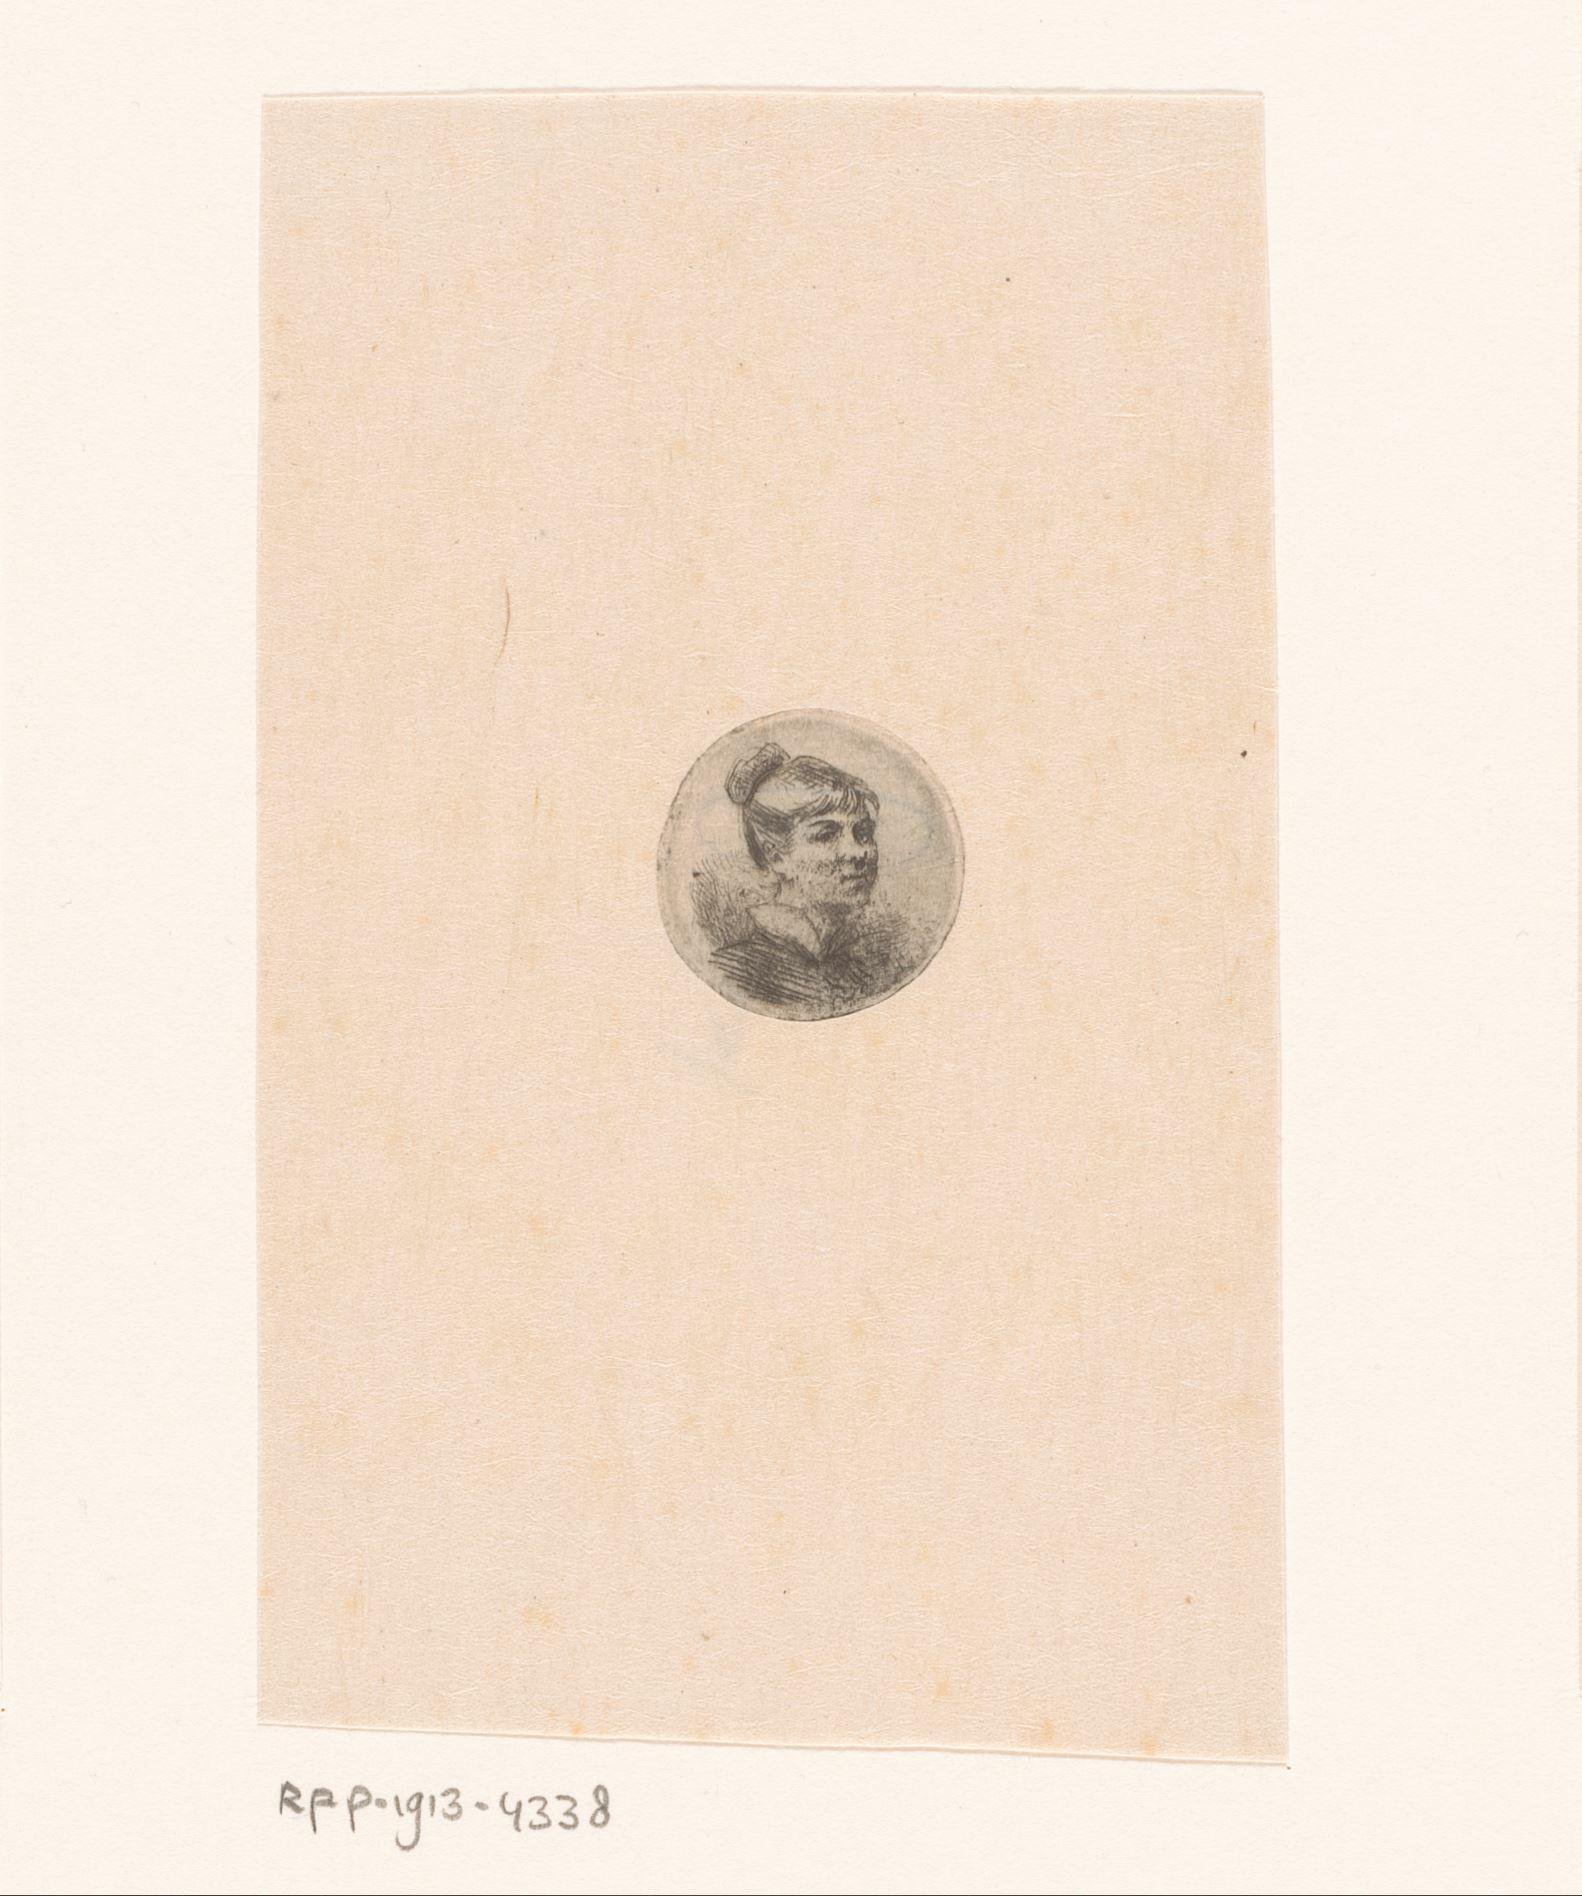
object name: print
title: Hoofd van een jonge vrouw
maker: adrien de witte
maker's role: print maker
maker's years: 1850-1935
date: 1860-1913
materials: paper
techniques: drypoint, etching, intaglio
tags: adult woman, head (human) - aa - female human figure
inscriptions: collector's mark: Lugt 2228